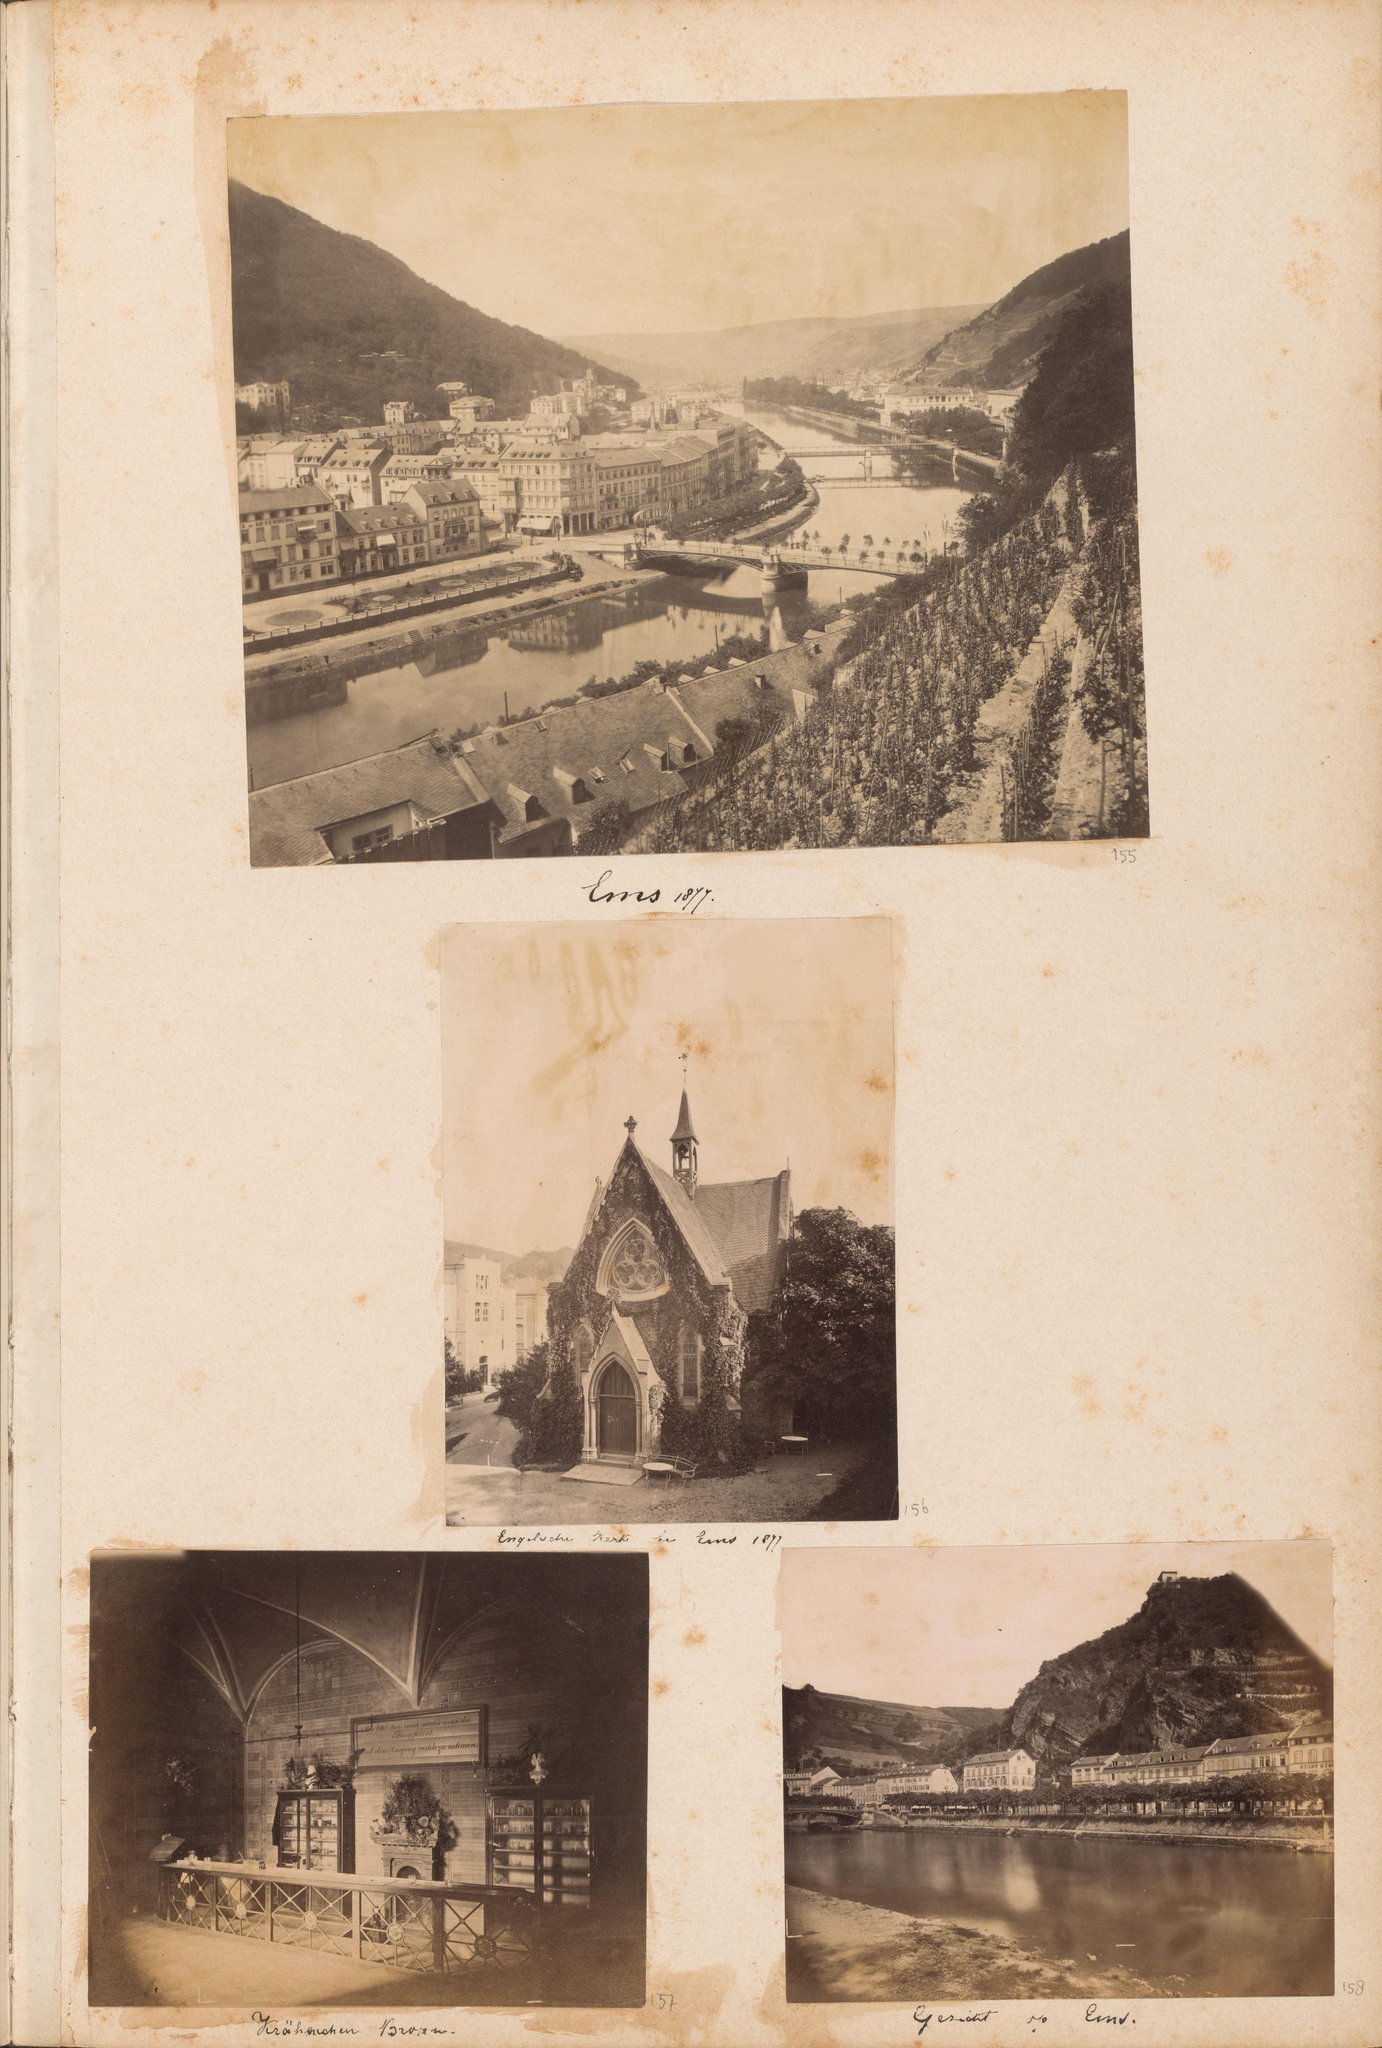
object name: album leaf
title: Bron in Bad Ems (Emser Kränchen)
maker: Anonymous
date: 1870-1880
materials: paper, photographic support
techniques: albumen print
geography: bad ems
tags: spring (fluids extracted from the earth)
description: Onderdeel van Fotoalbum van Robert Daniel Crommelin (1841-1907).